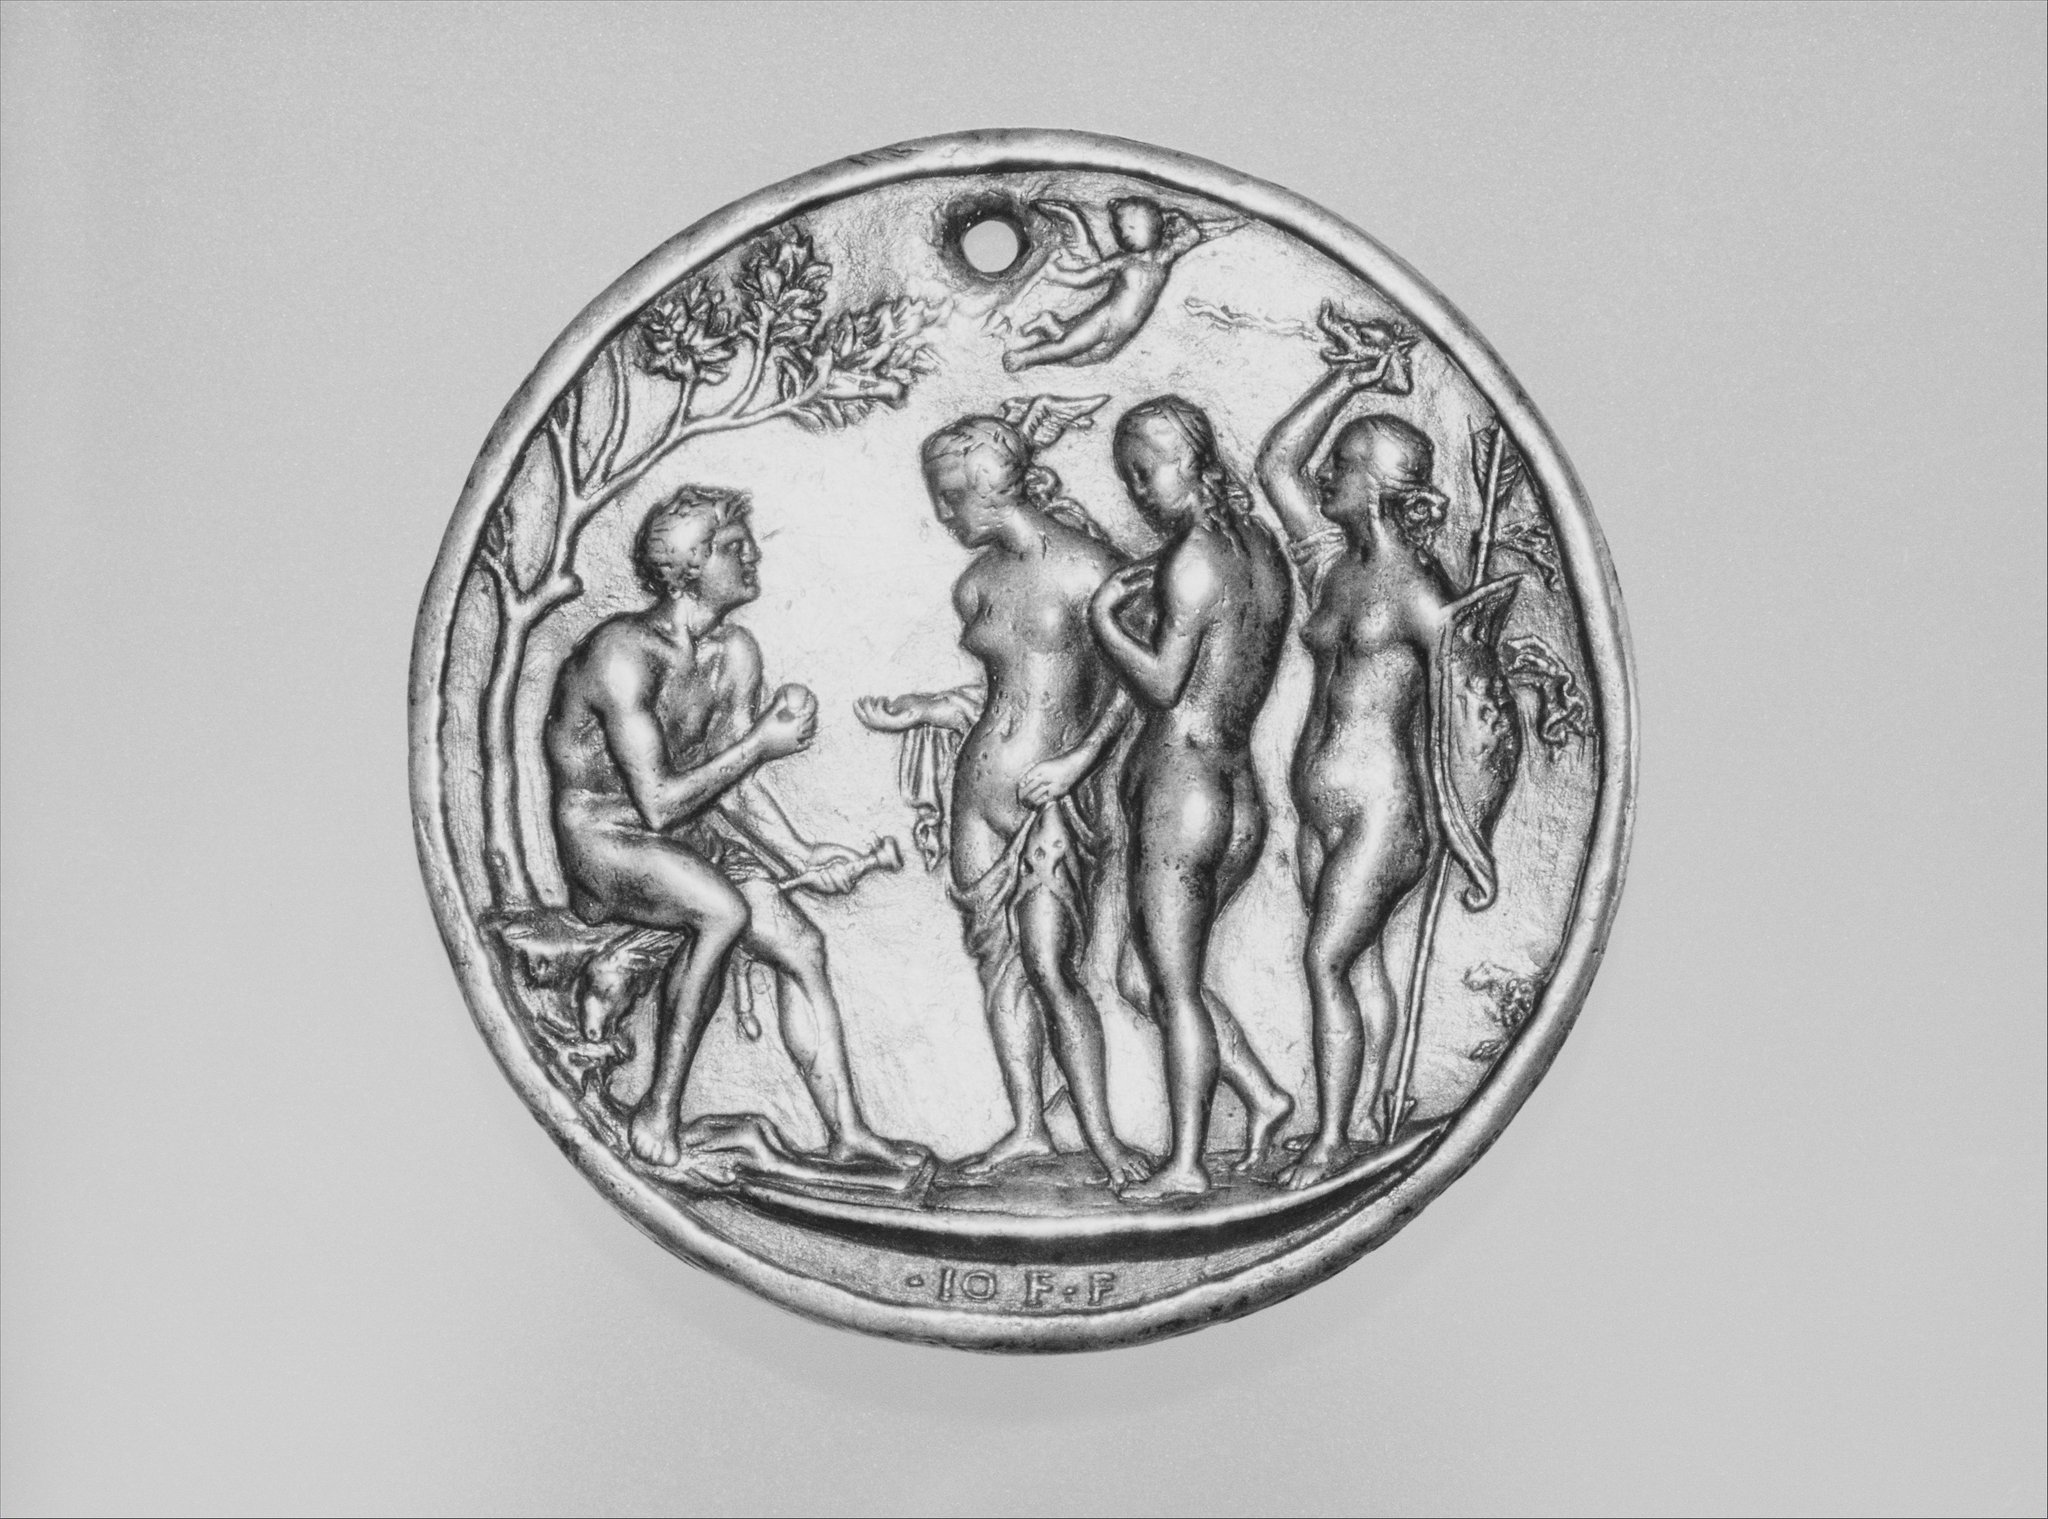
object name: plaquette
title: The Judgment of Paris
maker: master io. f.f.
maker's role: artist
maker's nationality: italian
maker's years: 1400-1550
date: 1501-1533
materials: bronze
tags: male nudes,female nudes